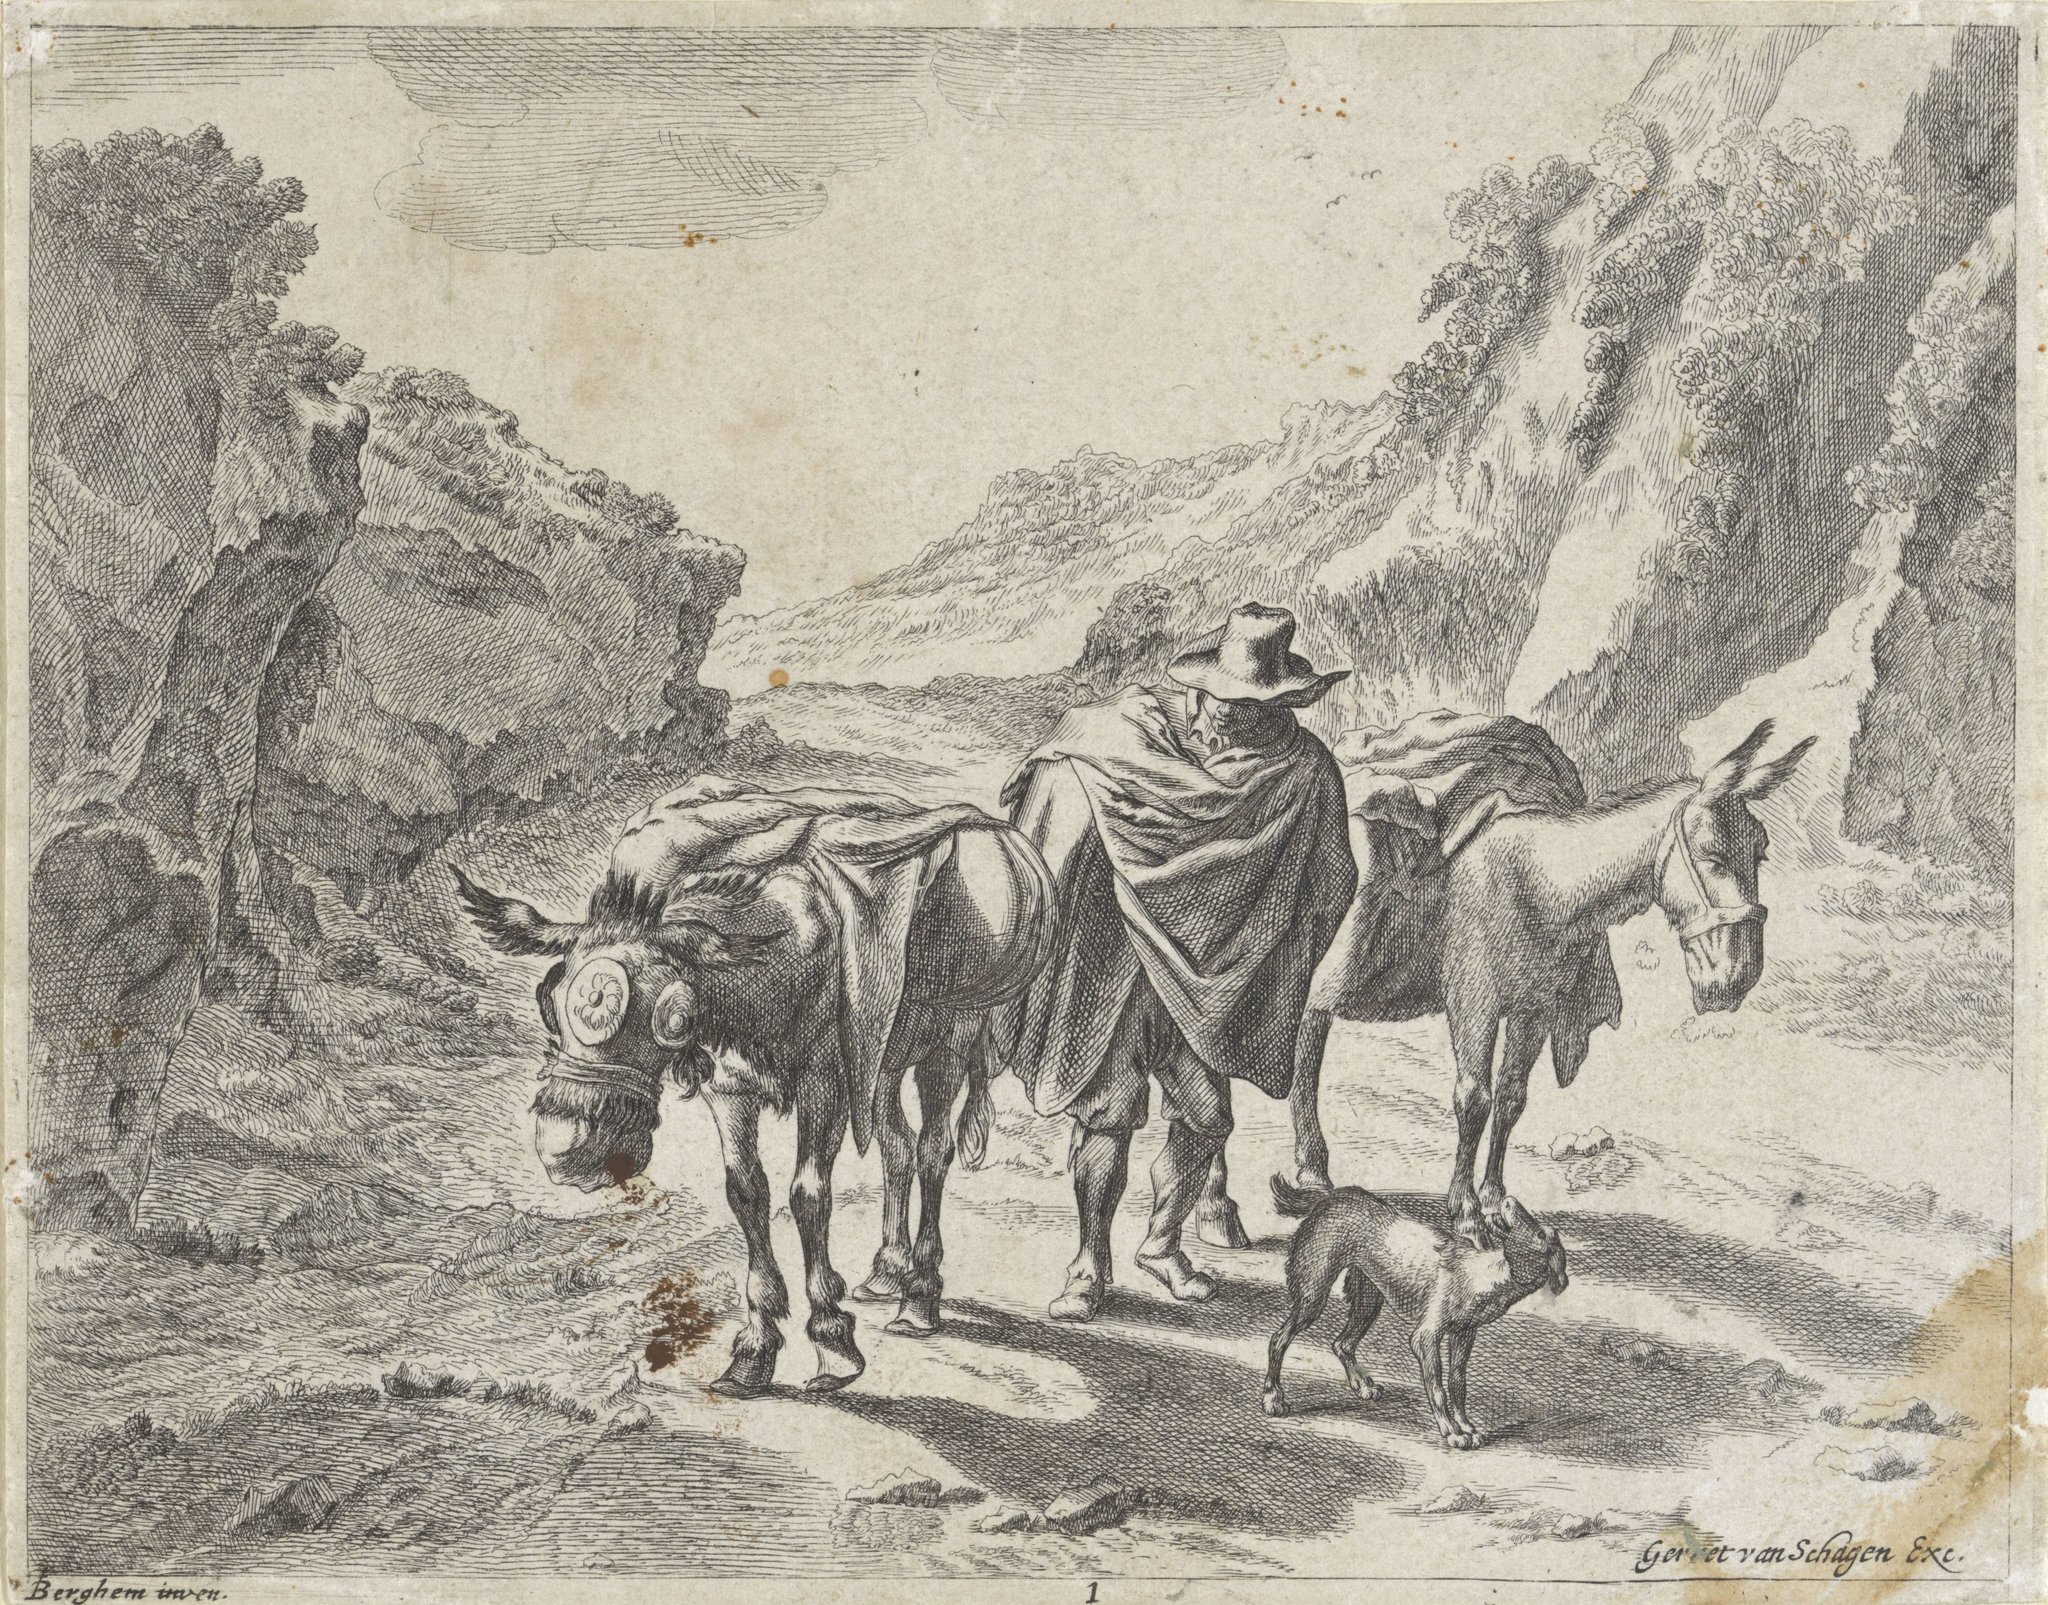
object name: print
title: Herder met twee ezels en een hond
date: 1677-1690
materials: paper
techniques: engraving, etching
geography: amsterdam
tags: ass, donkey, herding, herdsman, herdswoman, shepherd, shepherdess, cowherd, etc., dog